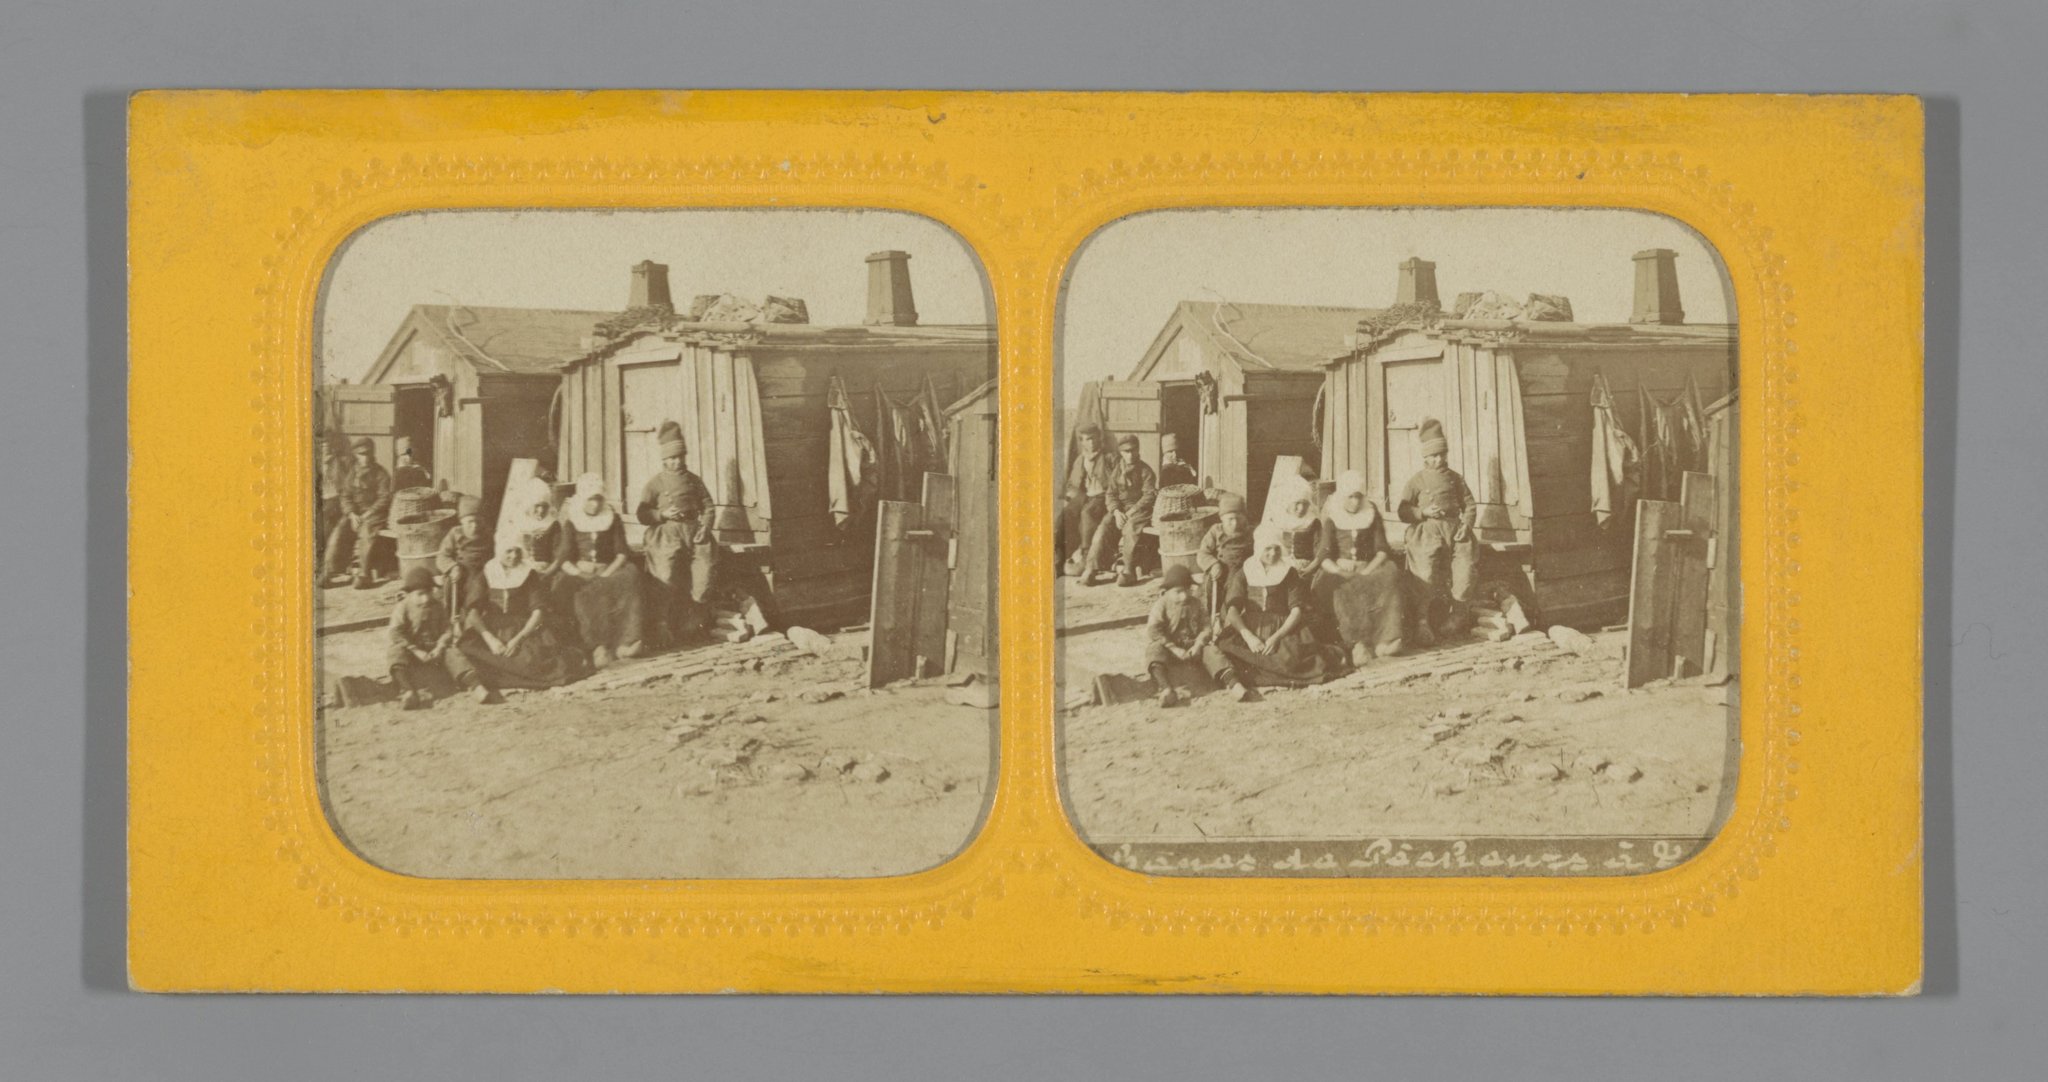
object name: tissue stereograph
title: Cabanes de pecheurs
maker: Anonymous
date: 1855-1875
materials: cardboard, paper, photographic support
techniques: albumen print, hand coloring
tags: hut, cabin, lodge, fisherman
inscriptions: title: ‘Cabanes de Pécheurs à (...)’, number: ‘20’